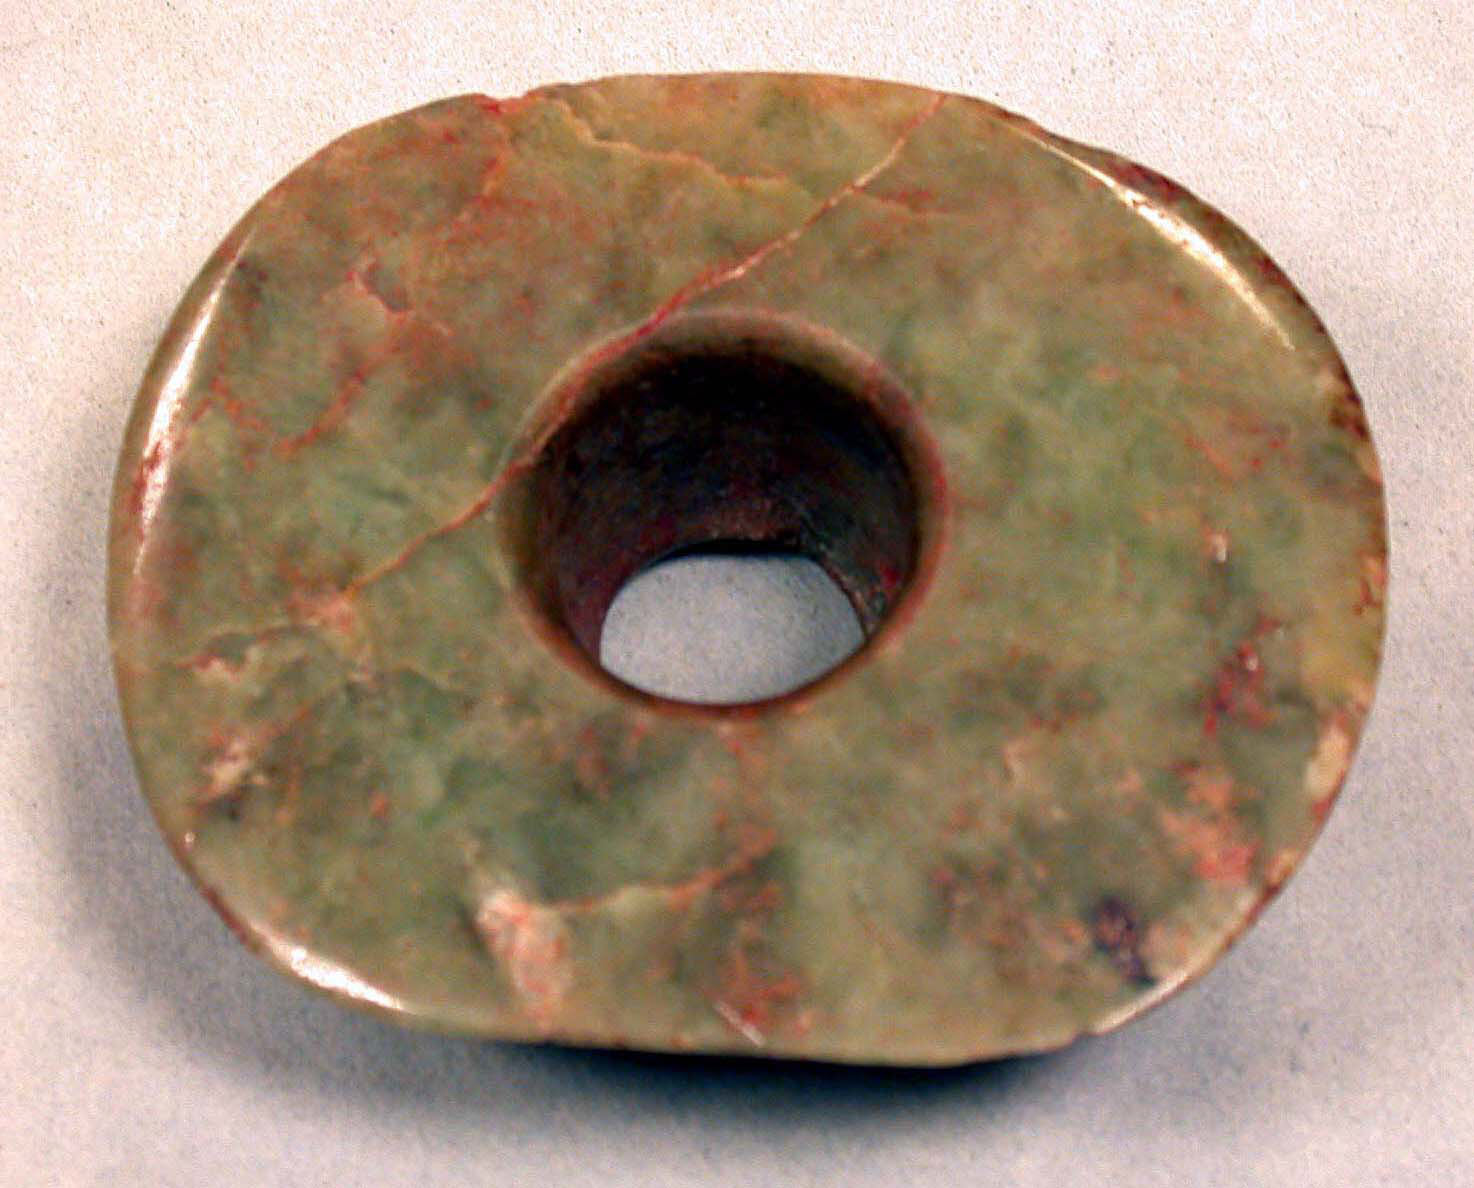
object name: earflare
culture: mexican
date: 1501-1600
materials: stone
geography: mexico